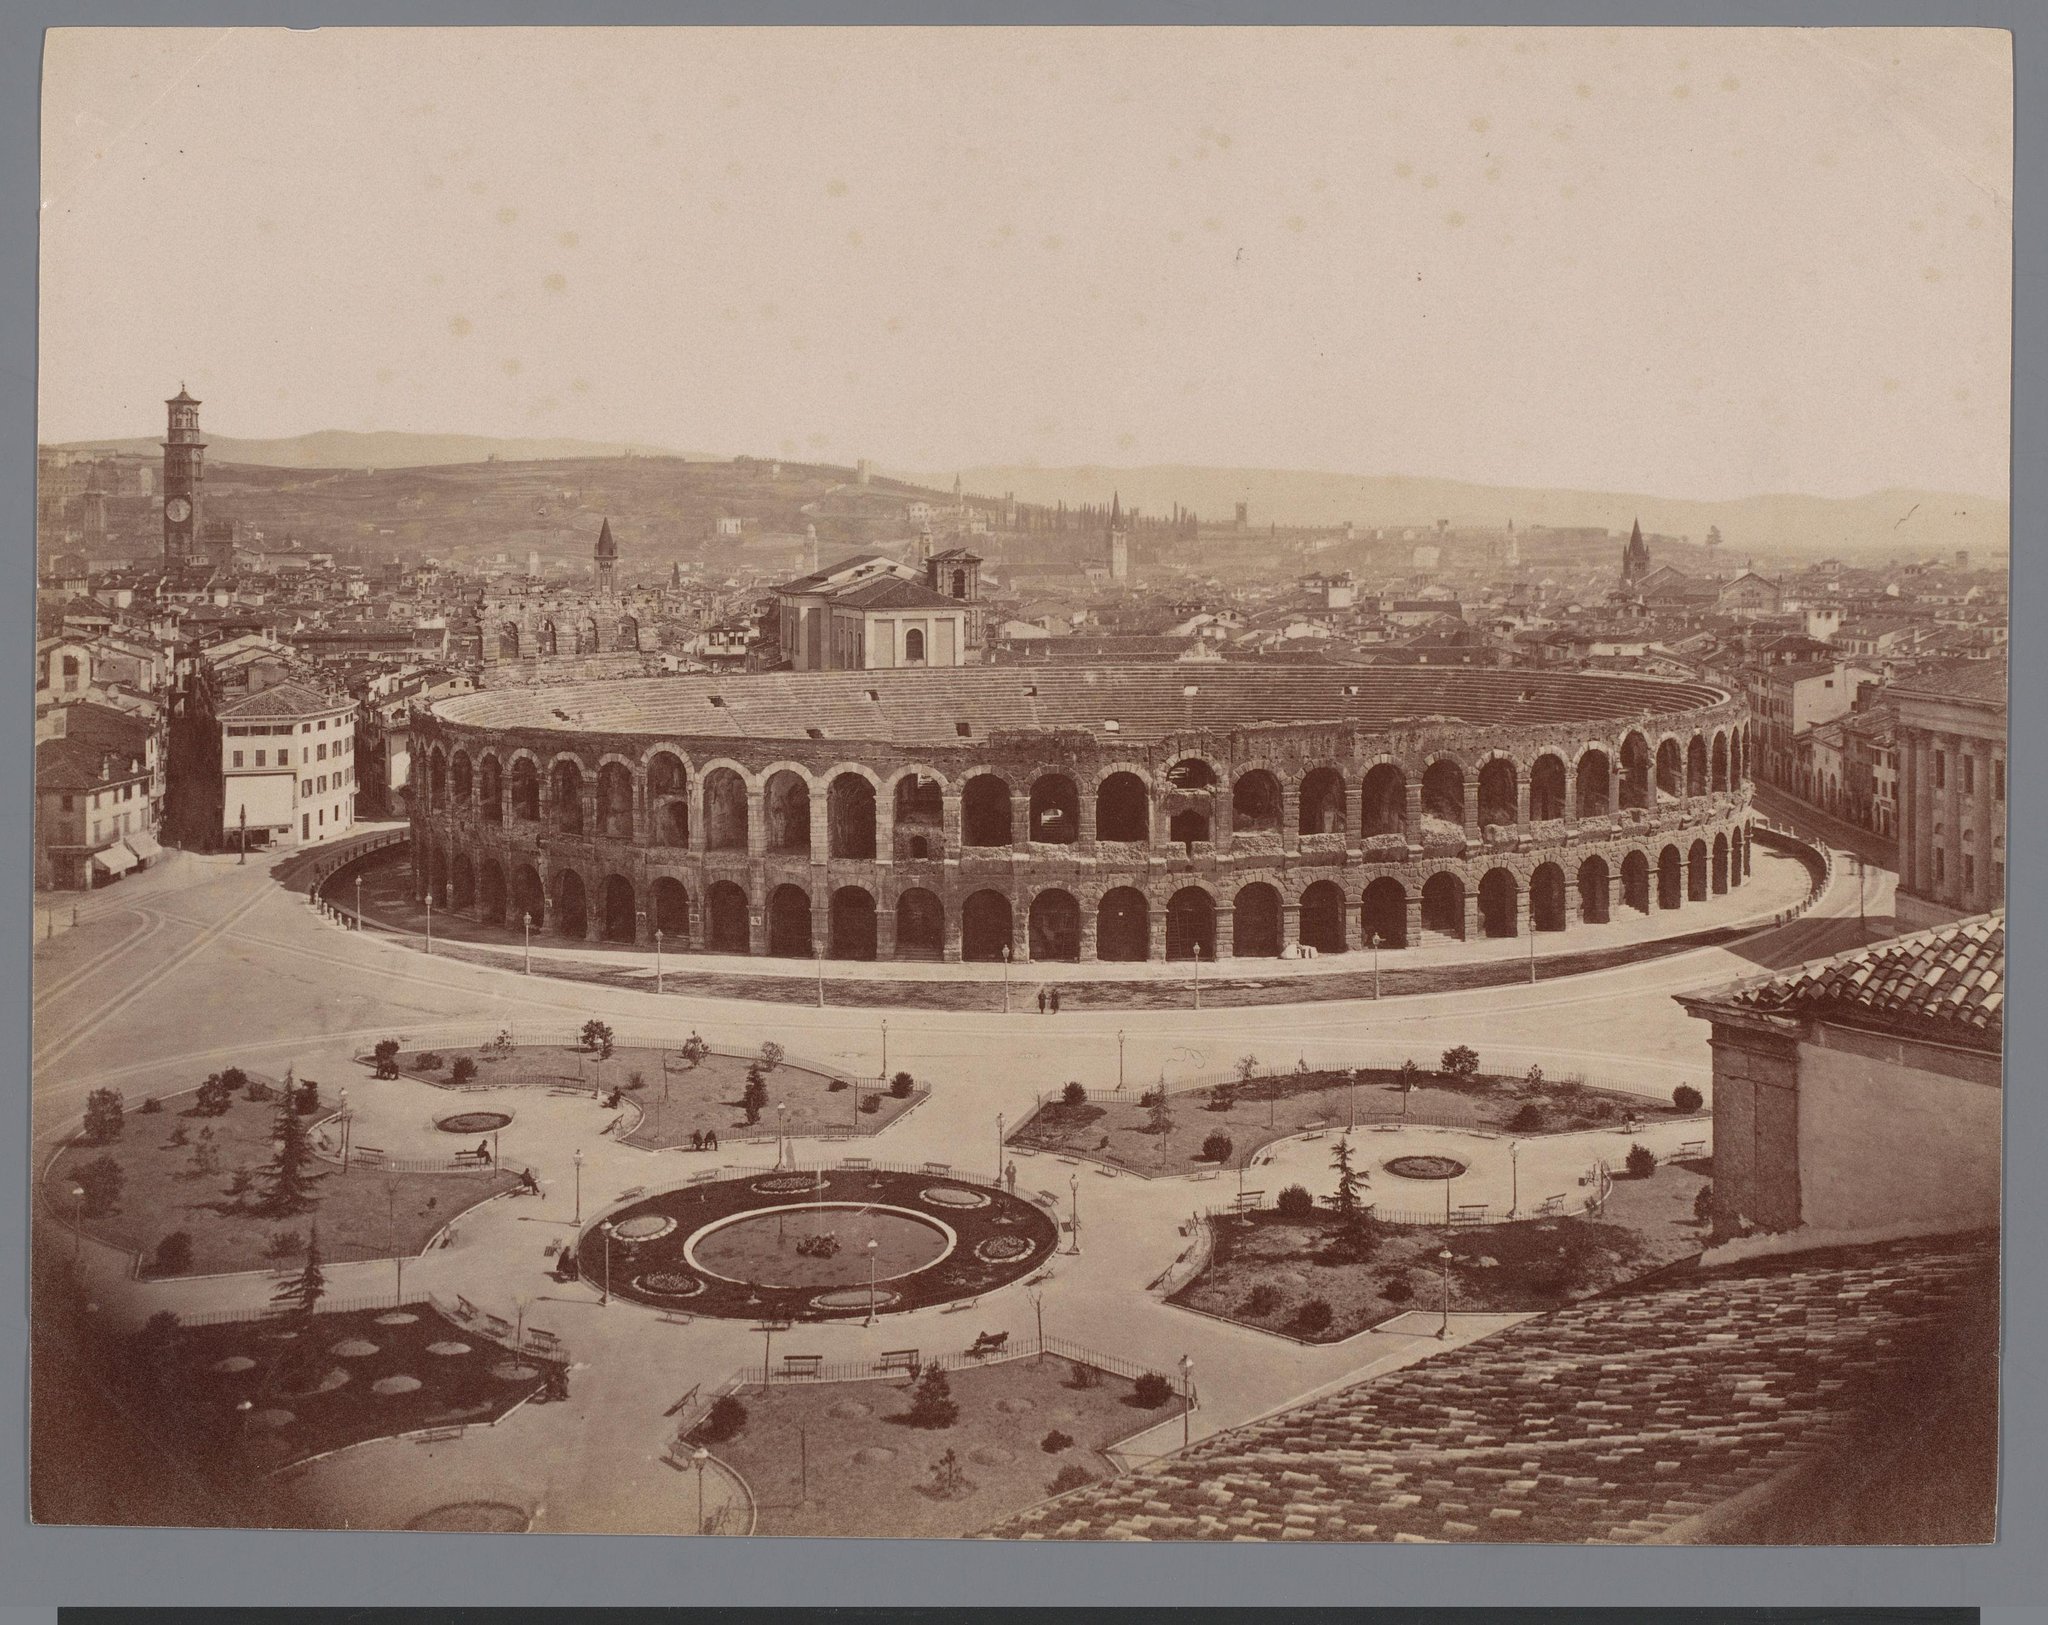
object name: photograph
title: Gezicht op de Arena van Verona, Italië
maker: Anonymous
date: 1851-1900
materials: cardboard, paper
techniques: albumen print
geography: verona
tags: city-view in general; 'veduta', amphitheatre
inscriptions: inscription: ‘Verona.’, number: ‘13’